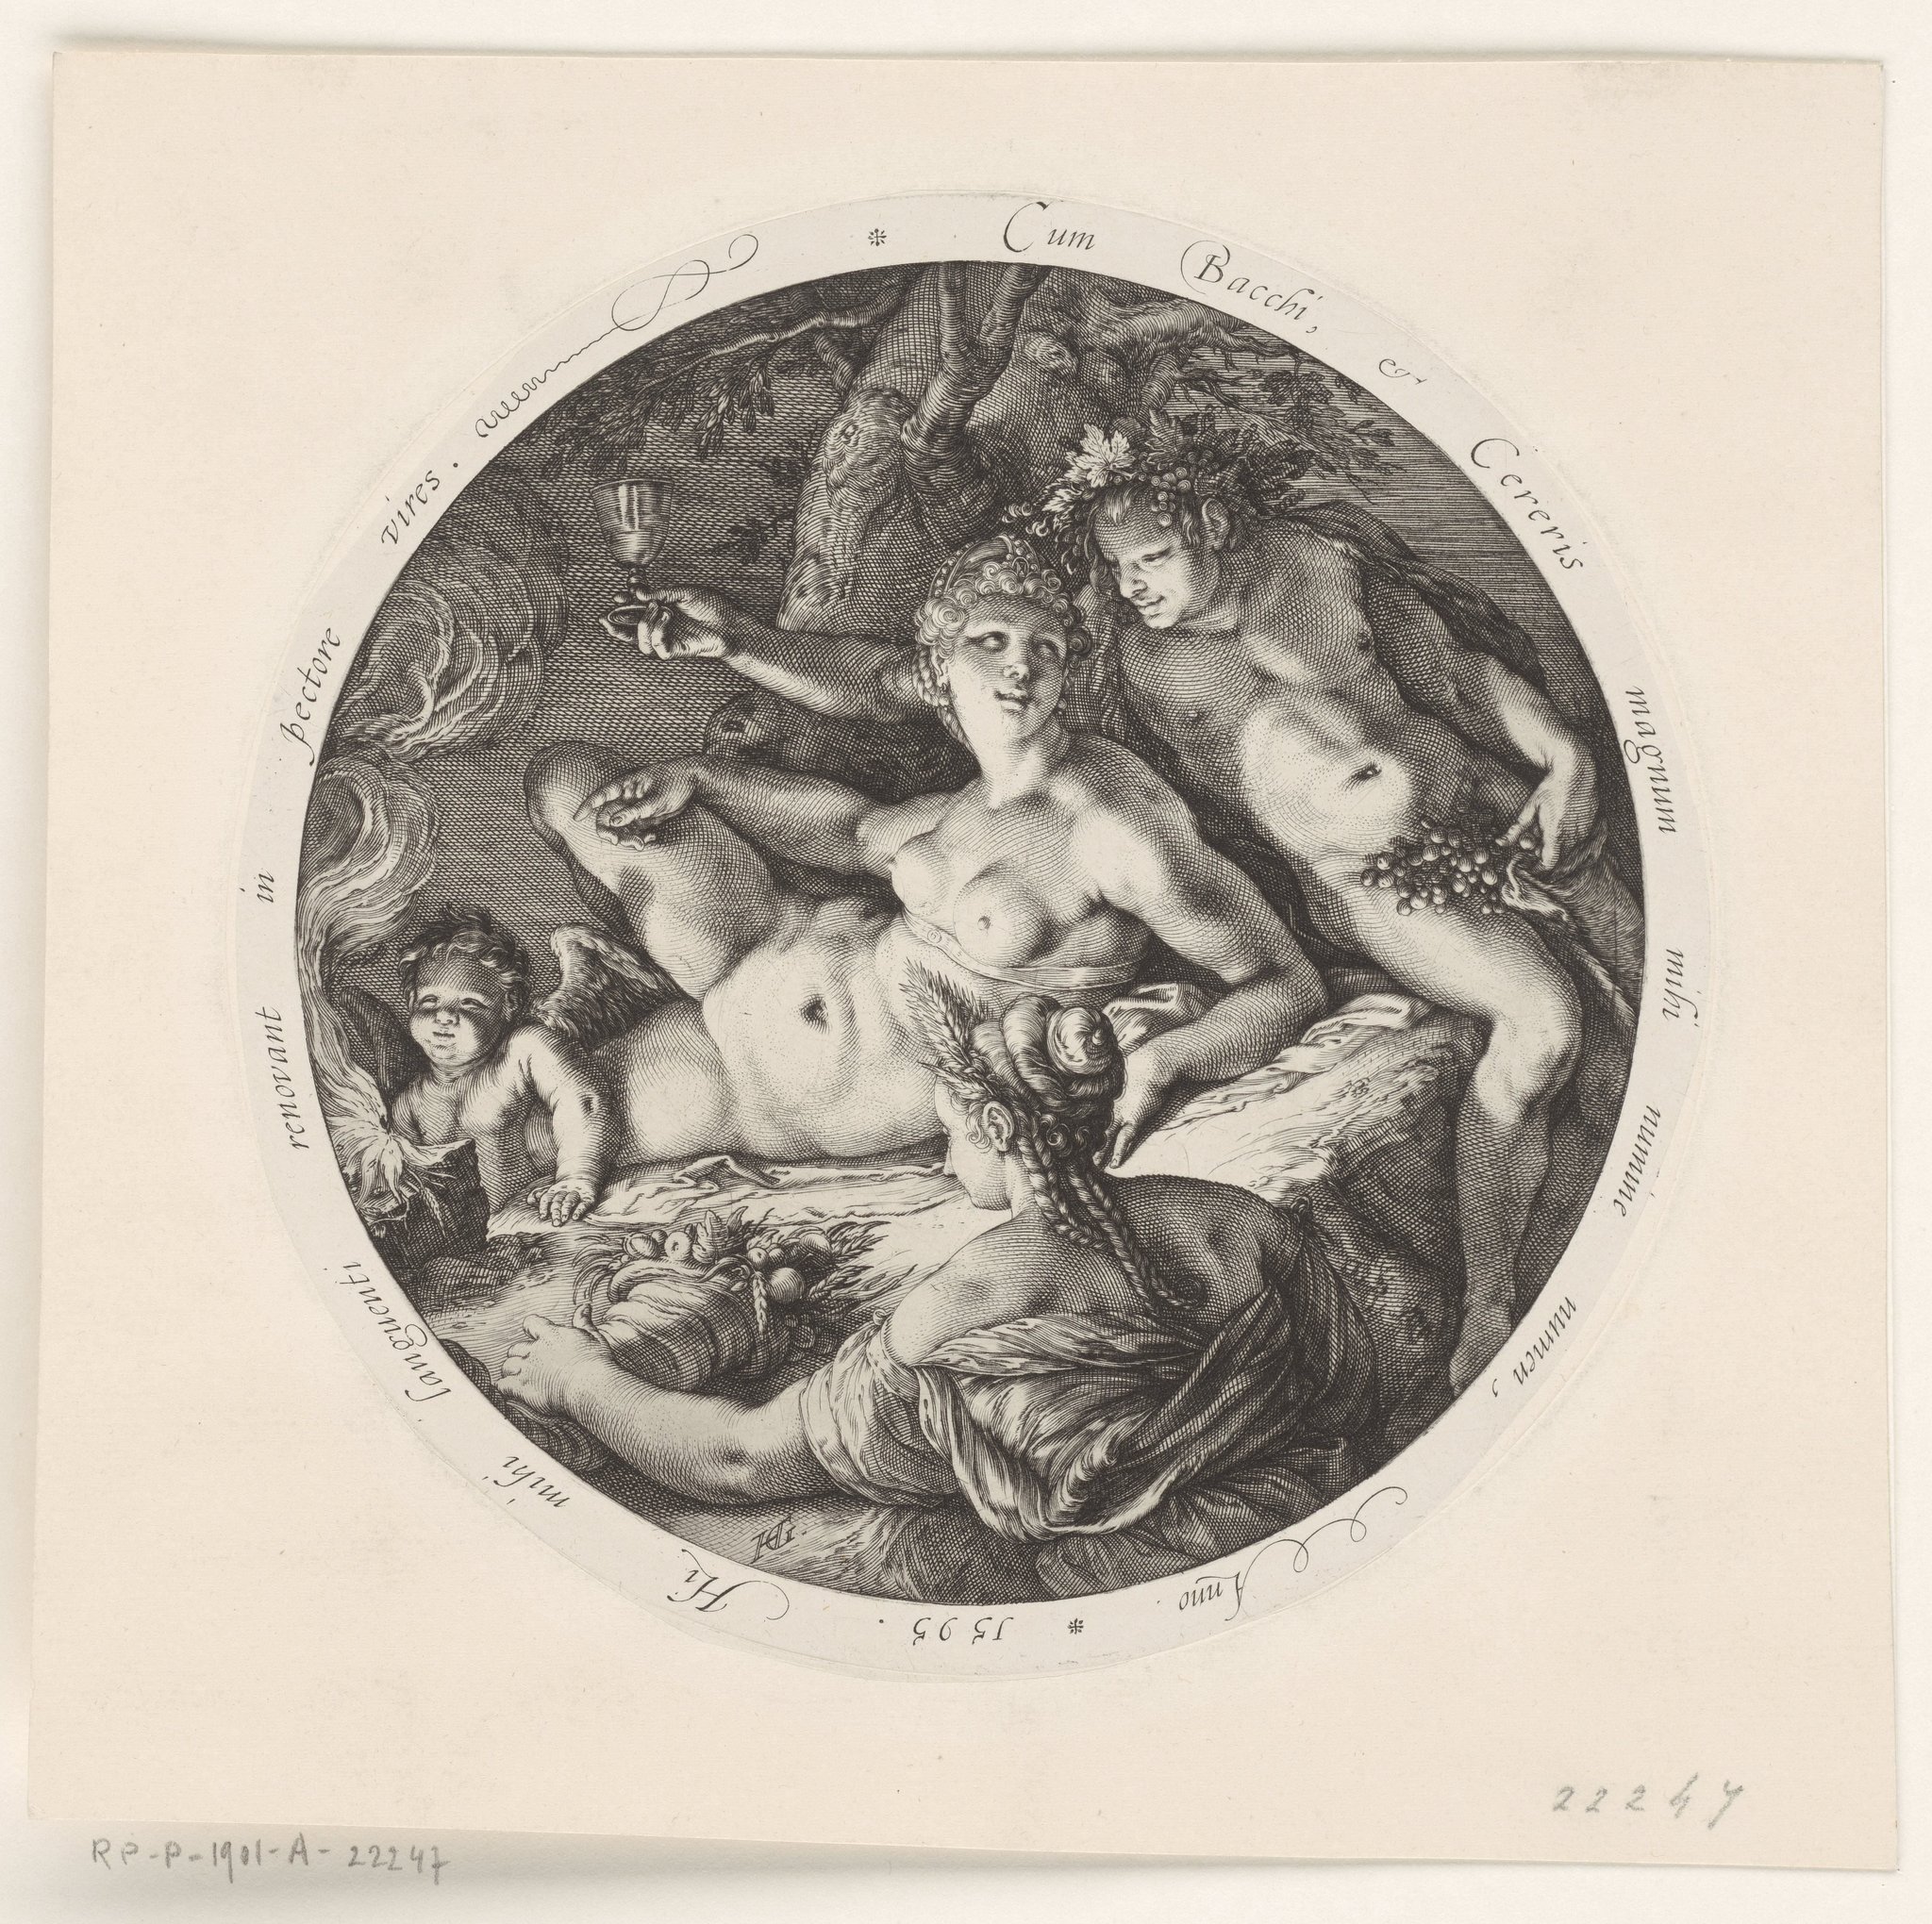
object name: print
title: Bacchus, Ceres en Venus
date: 1595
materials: paper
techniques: engraving on silver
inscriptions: monogram: ‘HG’, mark: ‘L. 906.’, mark: ‘L. 2228a’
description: Nachtstuk met Bacchus, Ceres, Venus en Cupido. Geplaatst in ovaal, Latijnse tekst rondom.